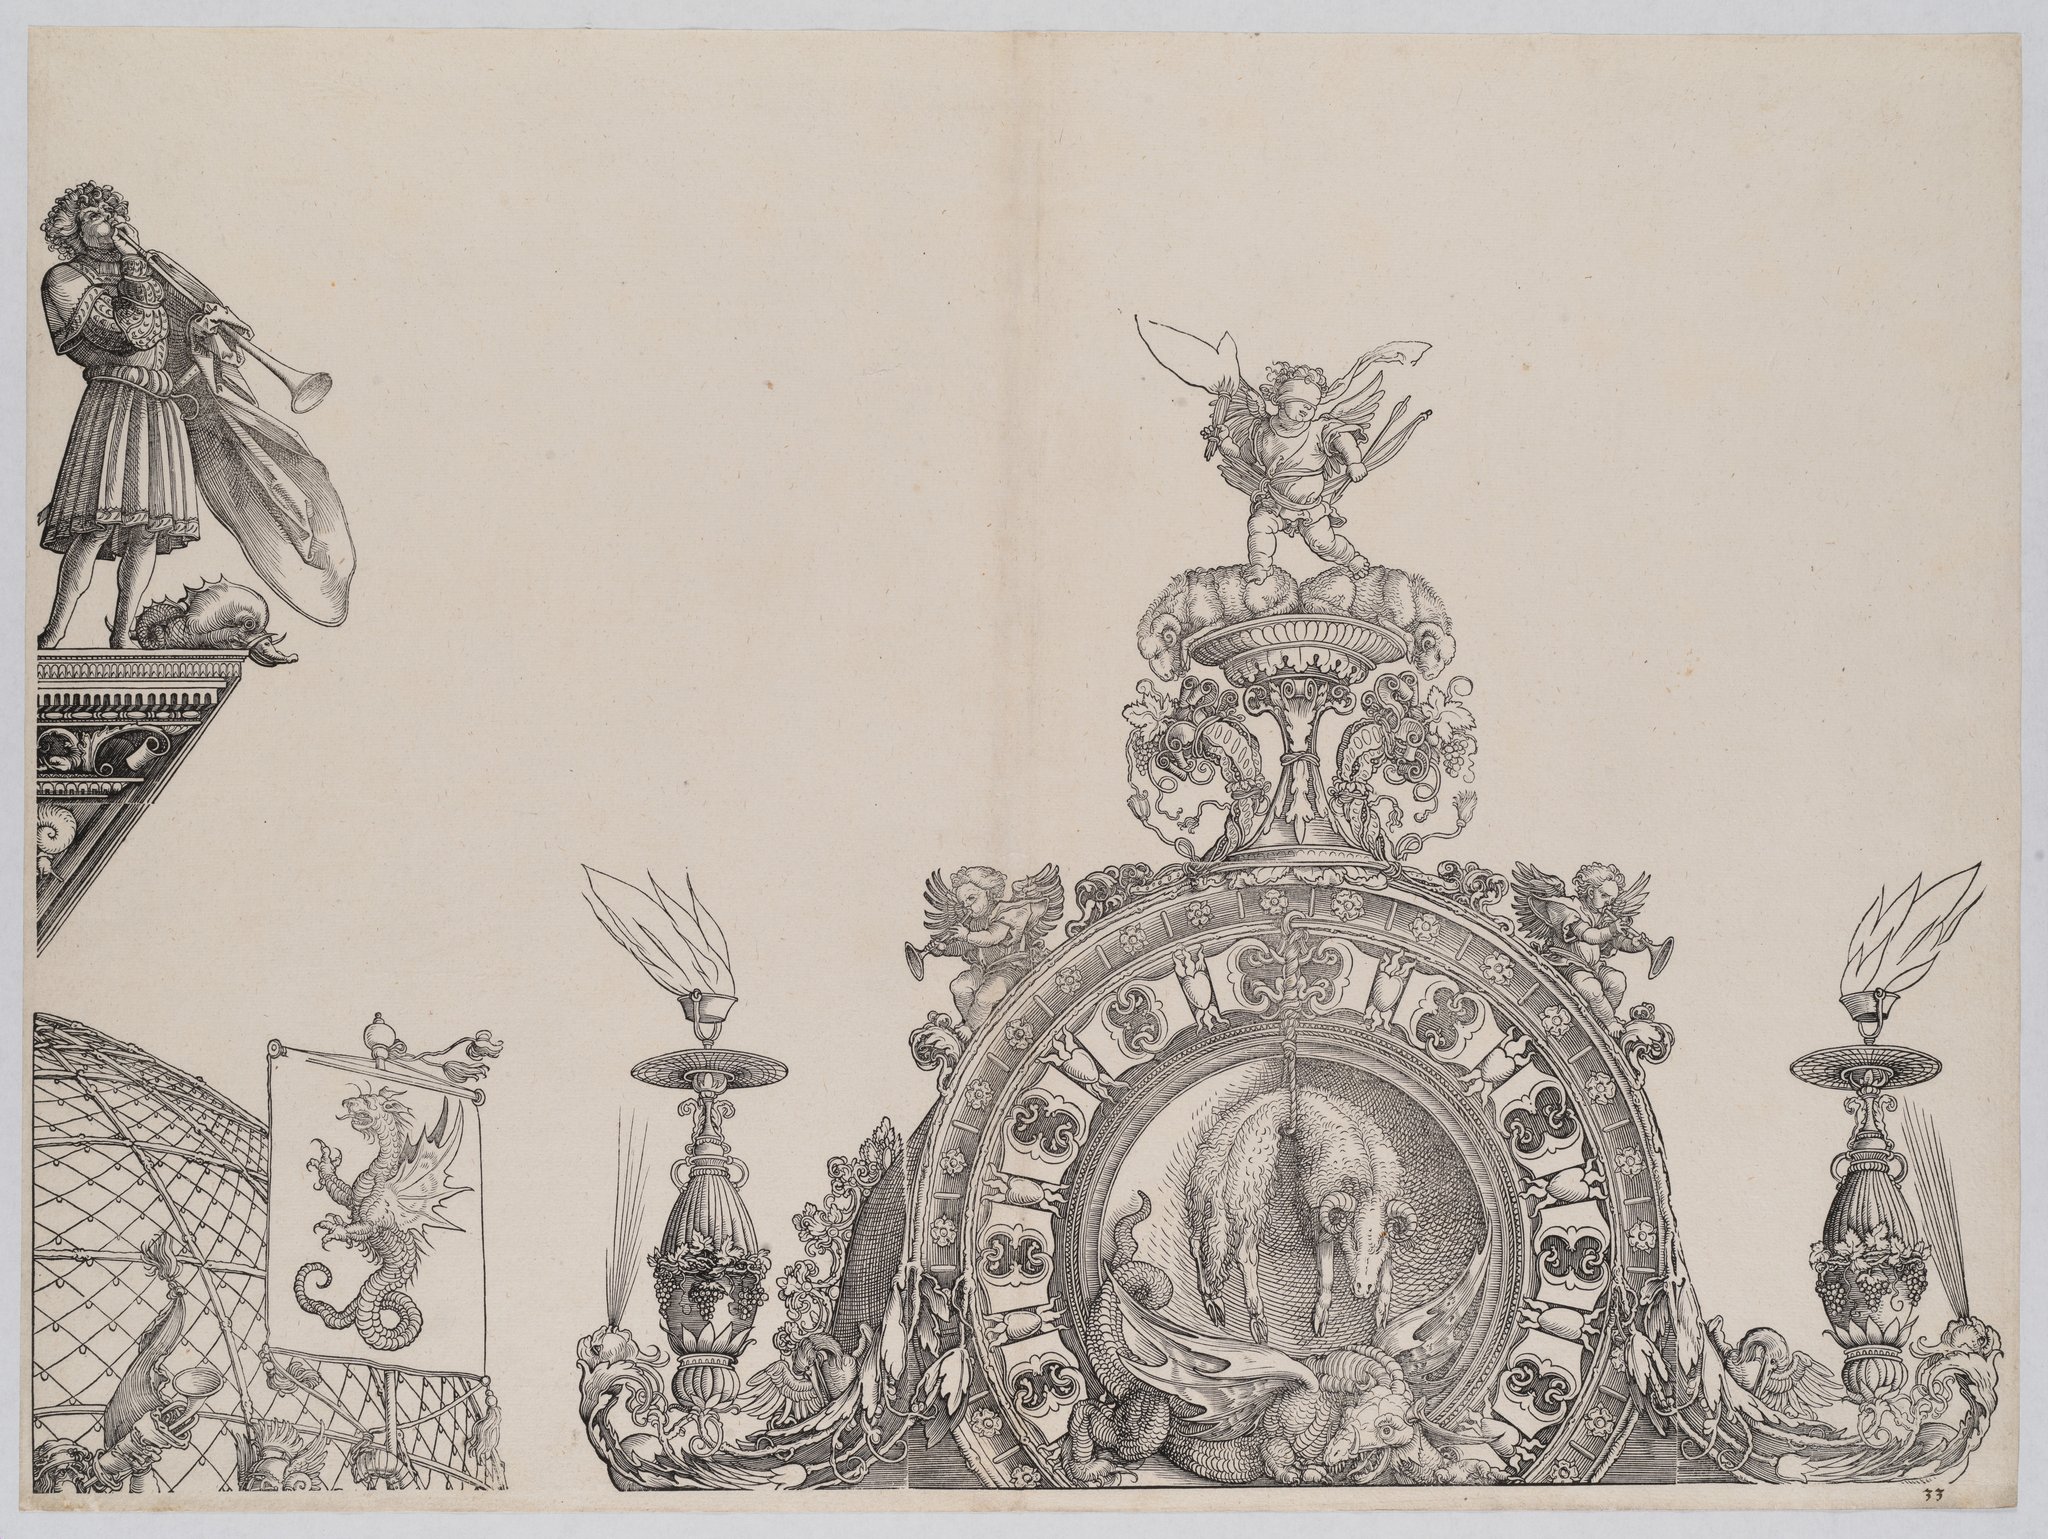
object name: print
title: The Pinnacle of the Right Portal; and a Trumpeter and Standard from the Central Portal, from the Arch of Honor, proof, dated 1515, printed 1517-18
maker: albrecht dürer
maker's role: artist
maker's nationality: german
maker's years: 1471-1528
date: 1515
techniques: woodcut